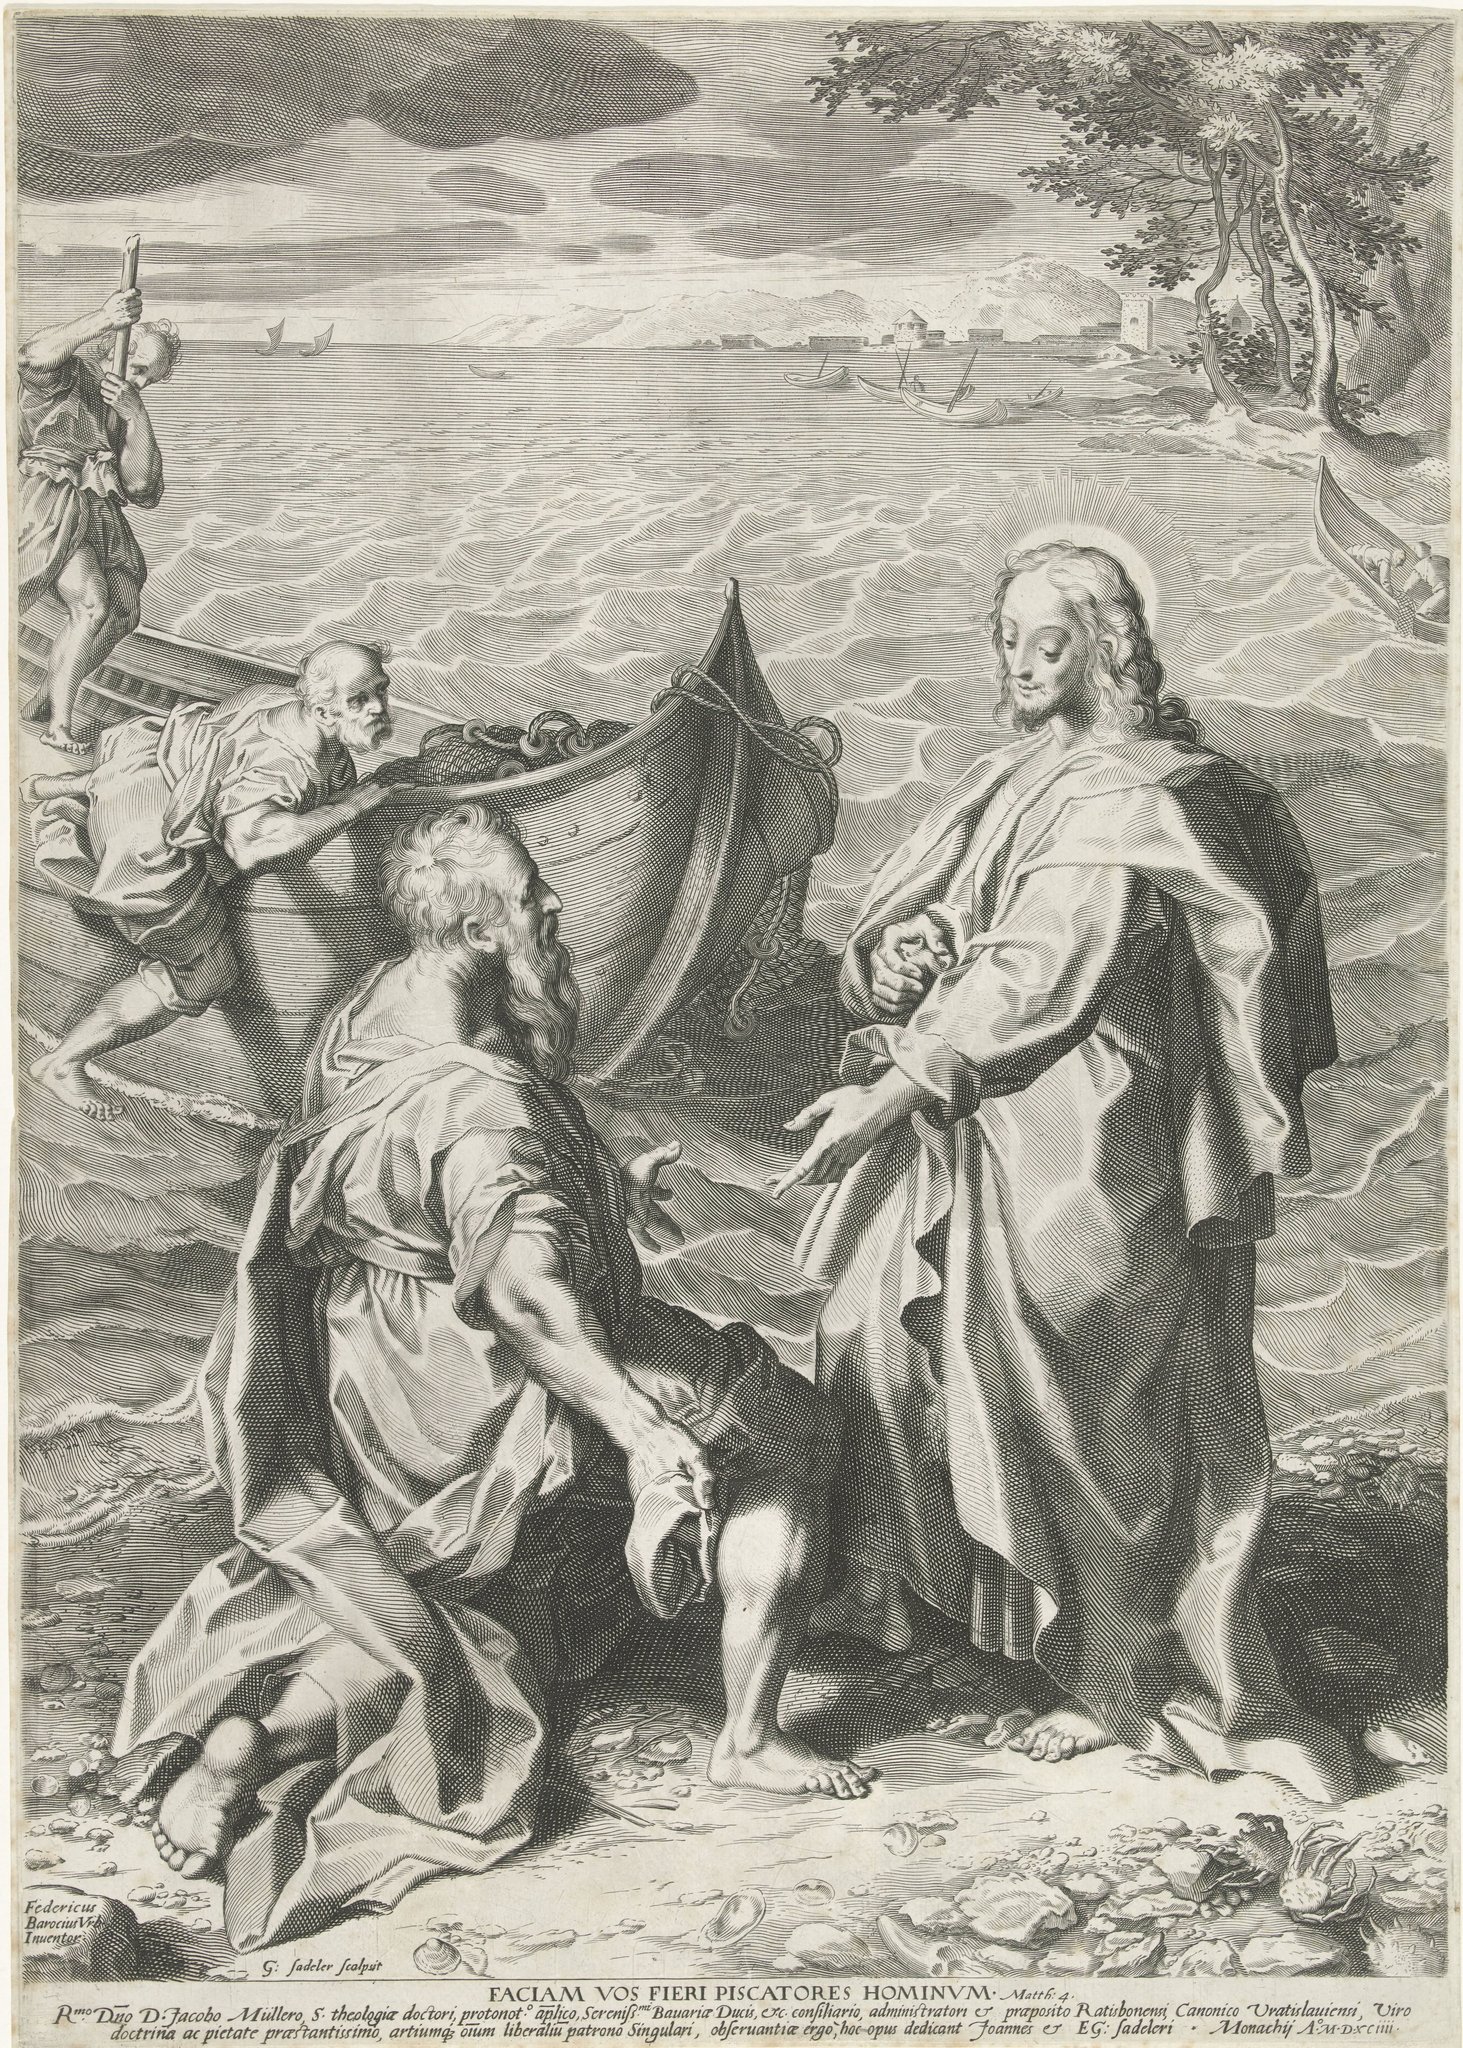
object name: print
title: Roeping van Petrus en Andreas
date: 1594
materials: paper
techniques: engraving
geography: munich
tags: calling of peter and andrew (john 1:40-42)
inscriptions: collector's mark: Lugt 240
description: Christus staat op de oever van het meer van Galilea. Andreas knielt voor hem, terwijl zijn broer Petrus uit de vissersboot klimt. De prent heeft een Latijns onderschrift met een opdracht aan de theoloog Jakob Müller.